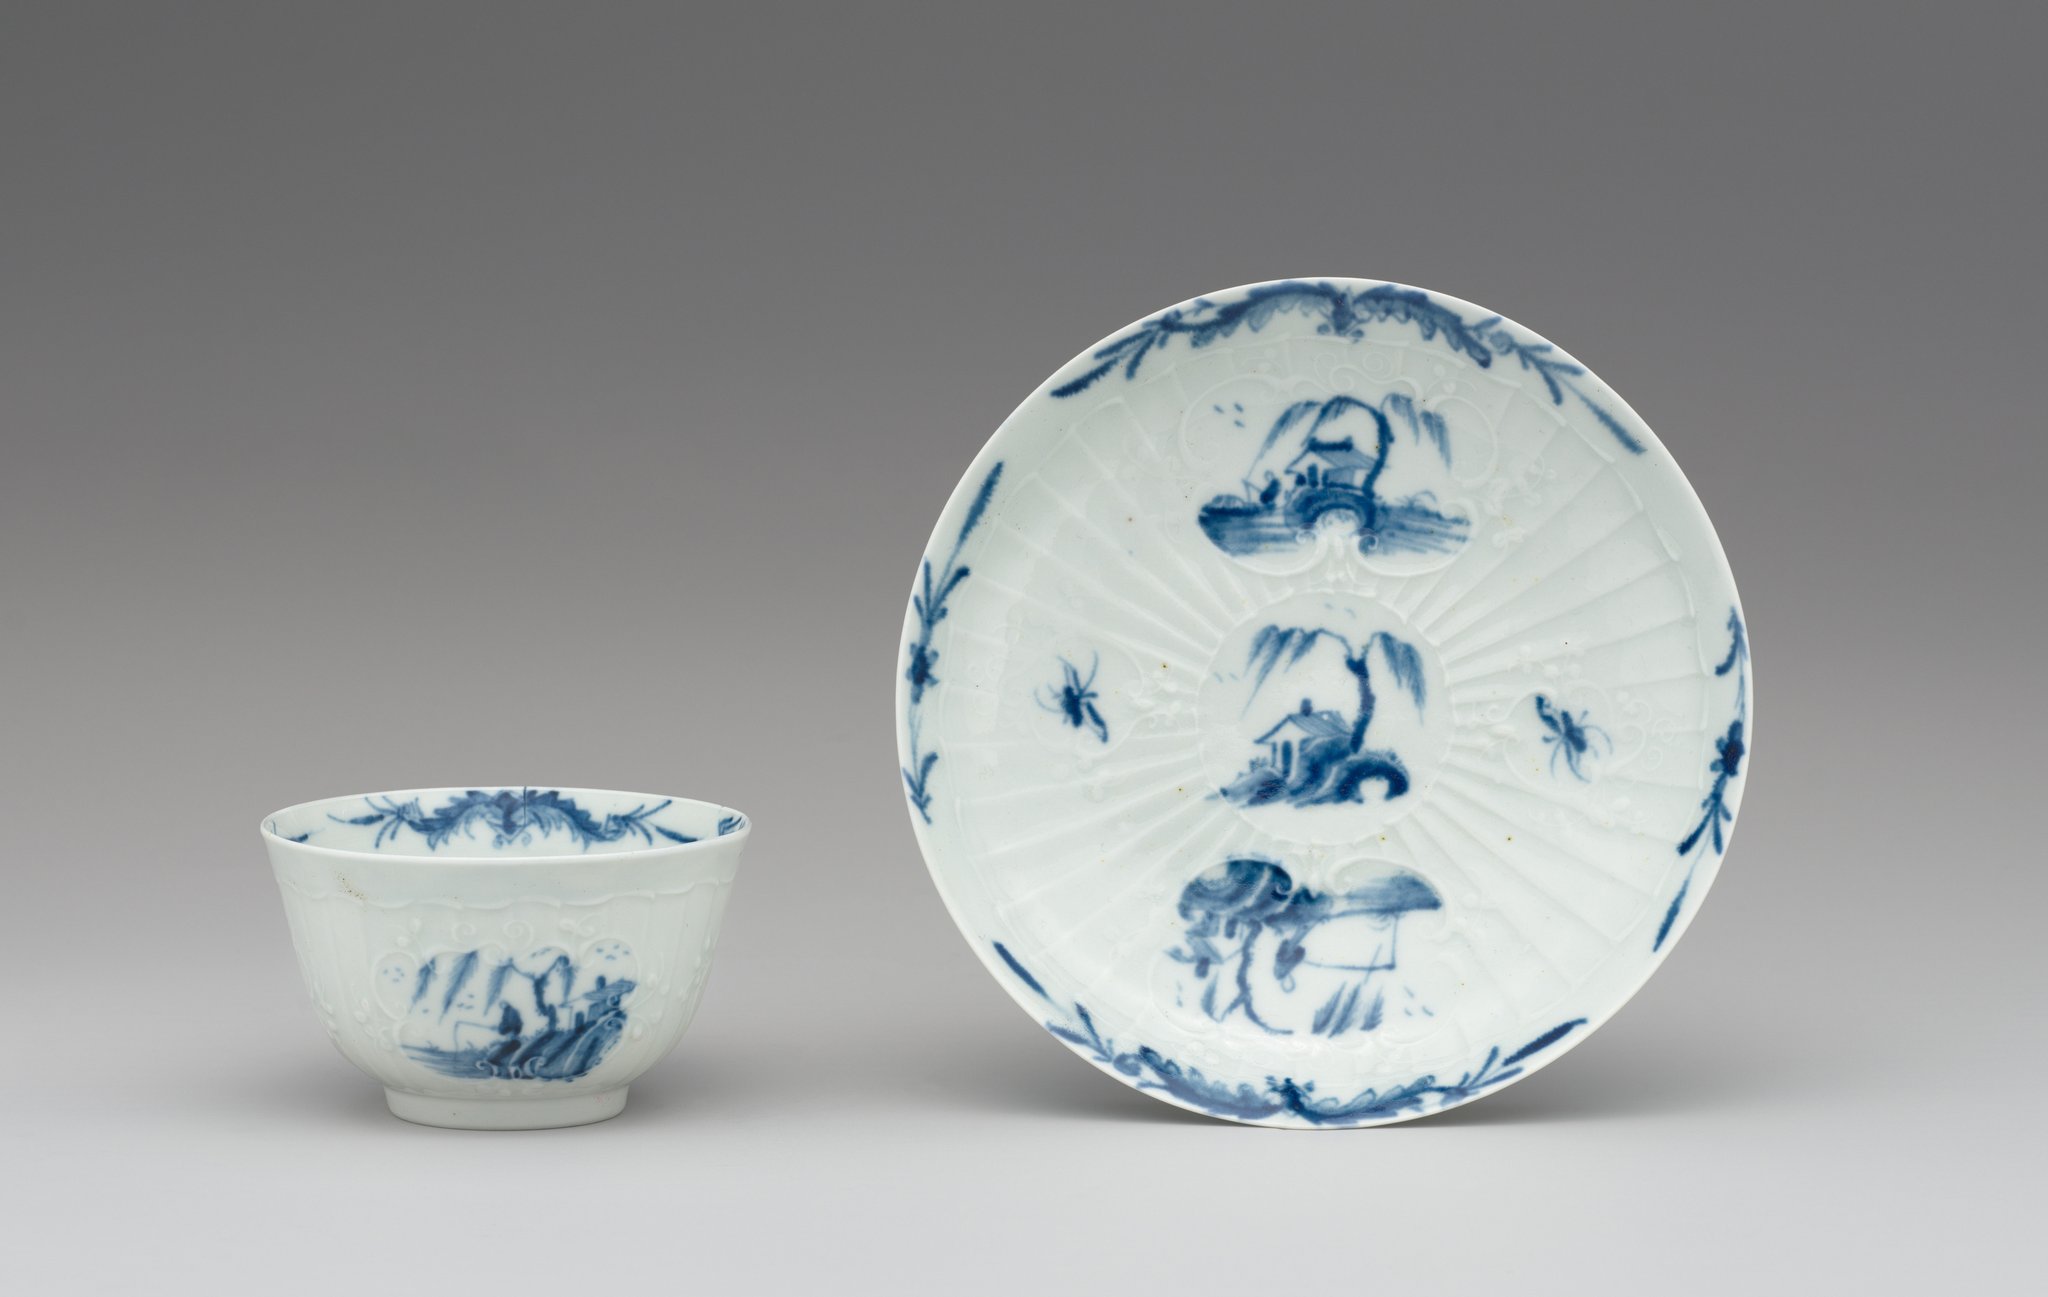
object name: teabowl and saucer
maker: worcester factory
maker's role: factory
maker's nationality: british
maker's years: 1751-2008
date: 1755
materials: soft paste porcelain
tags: insects